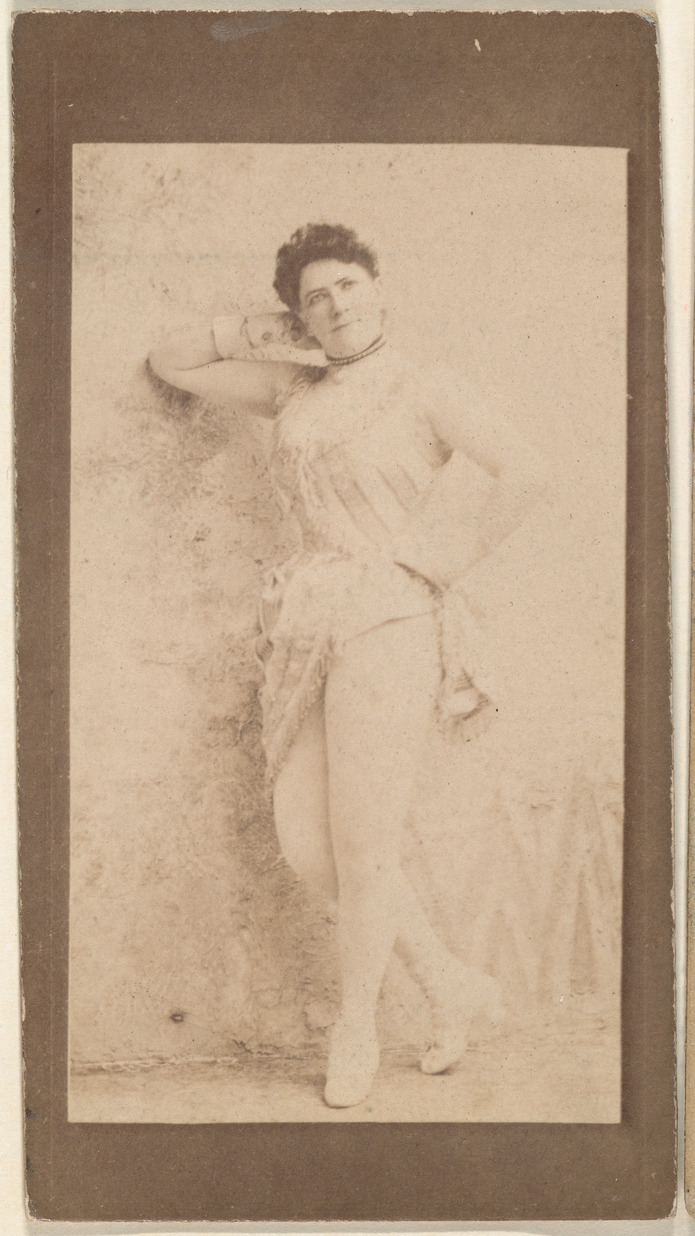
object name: photograph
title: Actress leaning against wall, from the Actresses series (N668)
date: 1888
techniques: albumen silver print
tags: portraits,women,actresses